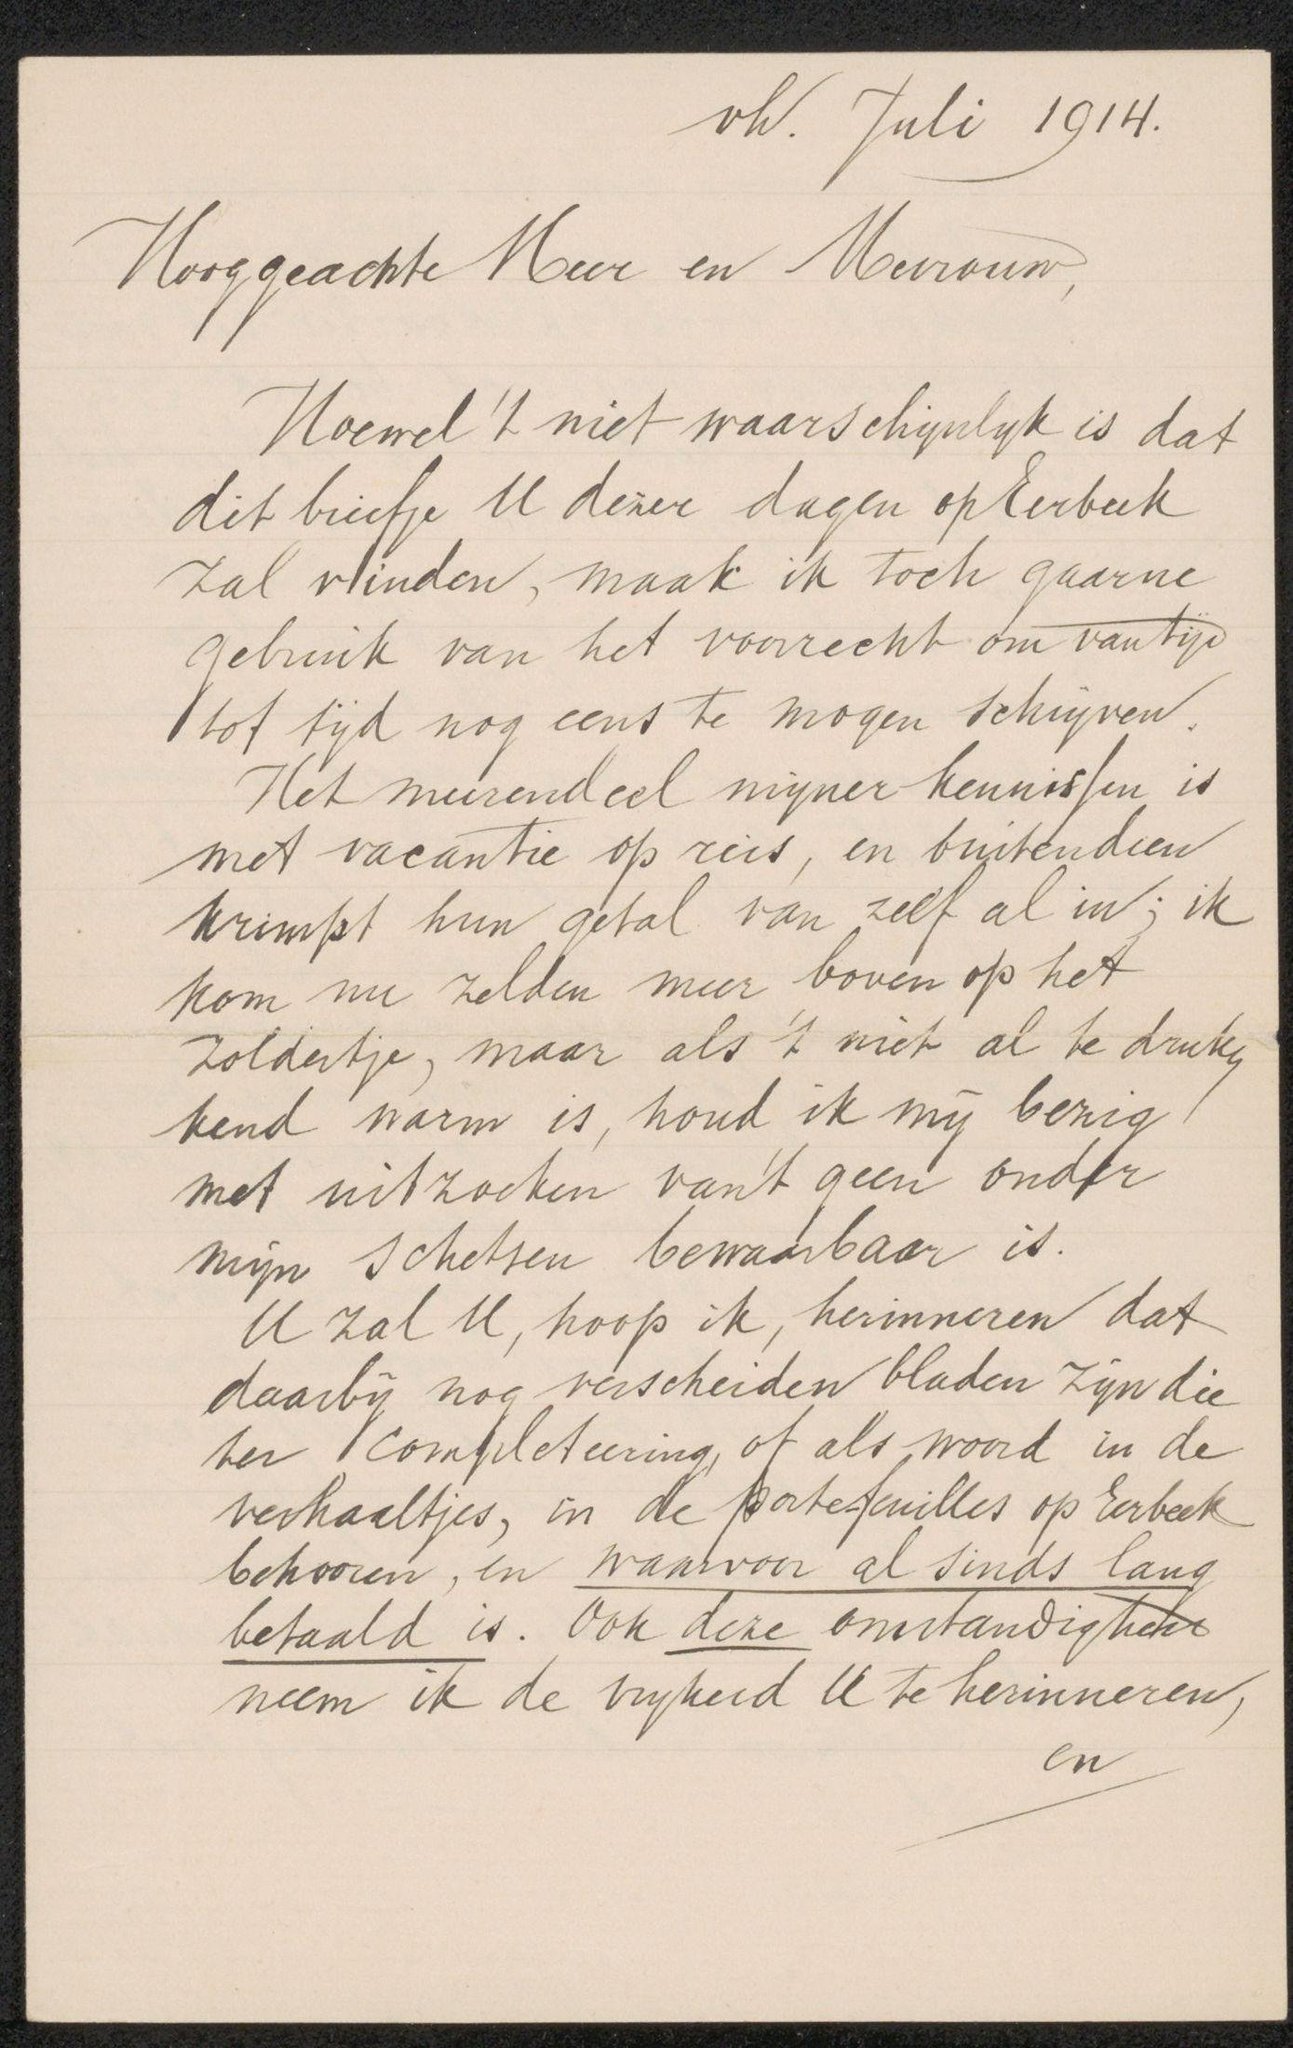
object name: letter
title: Brief aan Max Wilhelm Carl Weber en Anne Antoinette Weber-Van Bosse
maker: august allebé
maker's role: draughtsman, print maker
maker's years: 1838-1927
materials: ink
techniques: pen, writing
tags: dordrecht, amsterdam, painter, print maker, draughtsman, designer, jan veth, anne antoinette weber-van bosse, carel lodewijk dake, arnhem, louis stracké, the hague, cornelis veth, criticizing and discussing art, art criticism, art trade, art shop, drawing